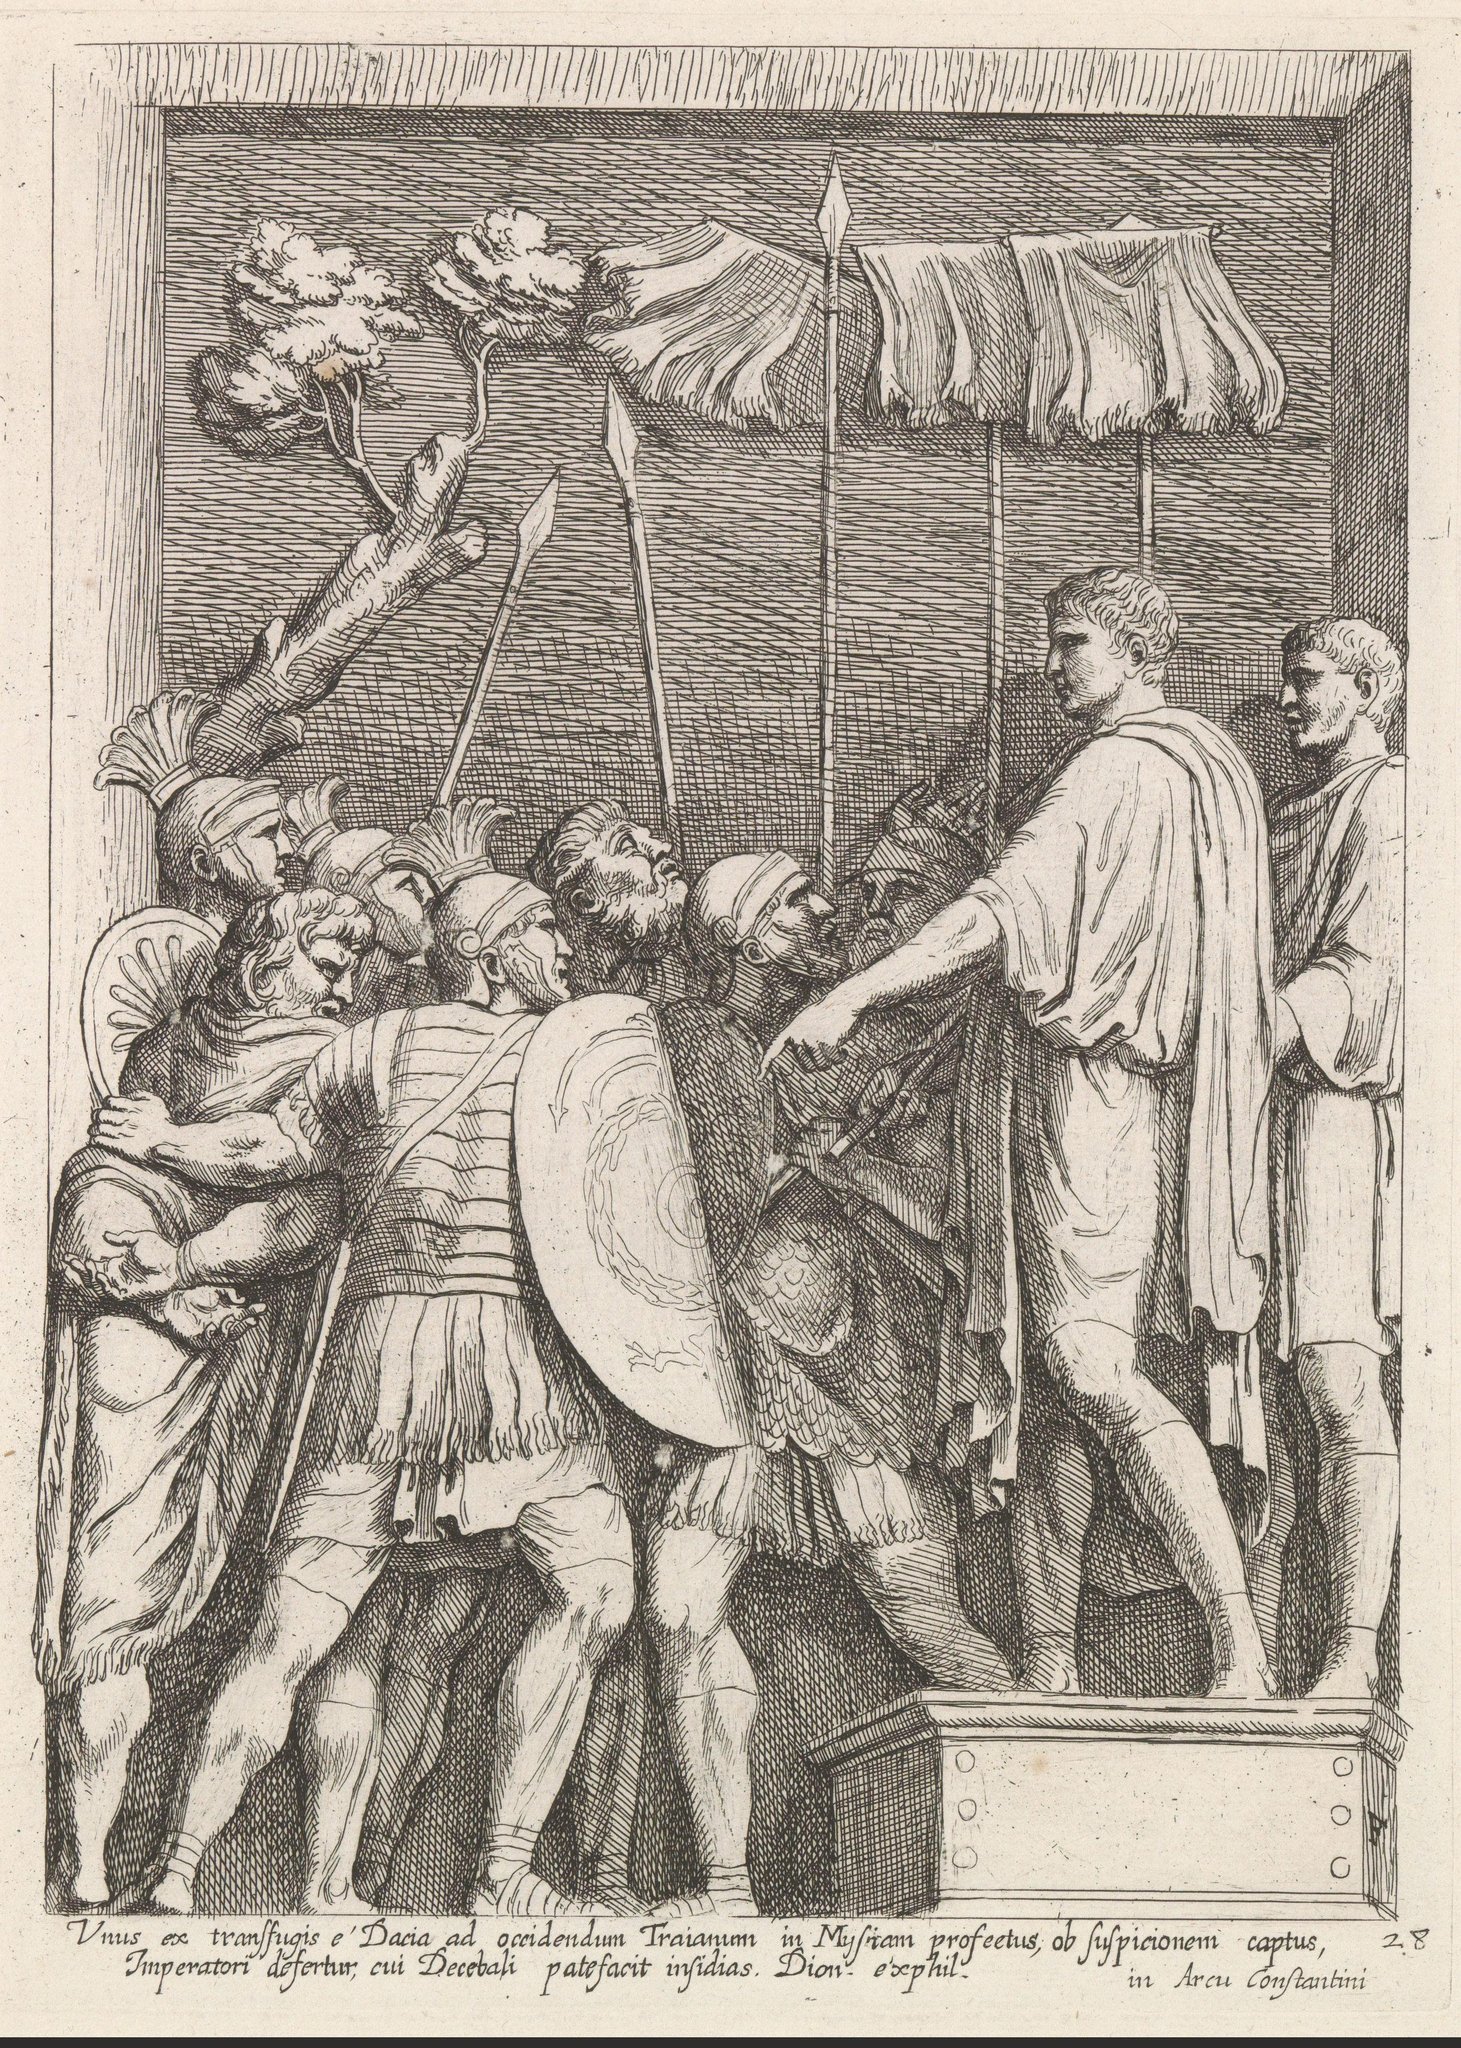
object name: print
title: Icones et segment (...)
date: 1645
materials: paper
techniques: etching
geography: paris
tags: piece of sculpture, reproduction of a piece of sculpture, the soldier; the soldier's life, ruler, sovereign, prisoner of war (after the battle), arch of constantine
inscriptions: number: ‘55’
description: Deze prent maakt deel uit van een reeks van 54 prenten (+ titelprent) naar antieke reliëfs. De nummering op de prenten loopt van 1 tot en met 50. Sommige prenten hebben dubbele nummers. Naar de reliëfs op de Boog van Constantijn te Rome.